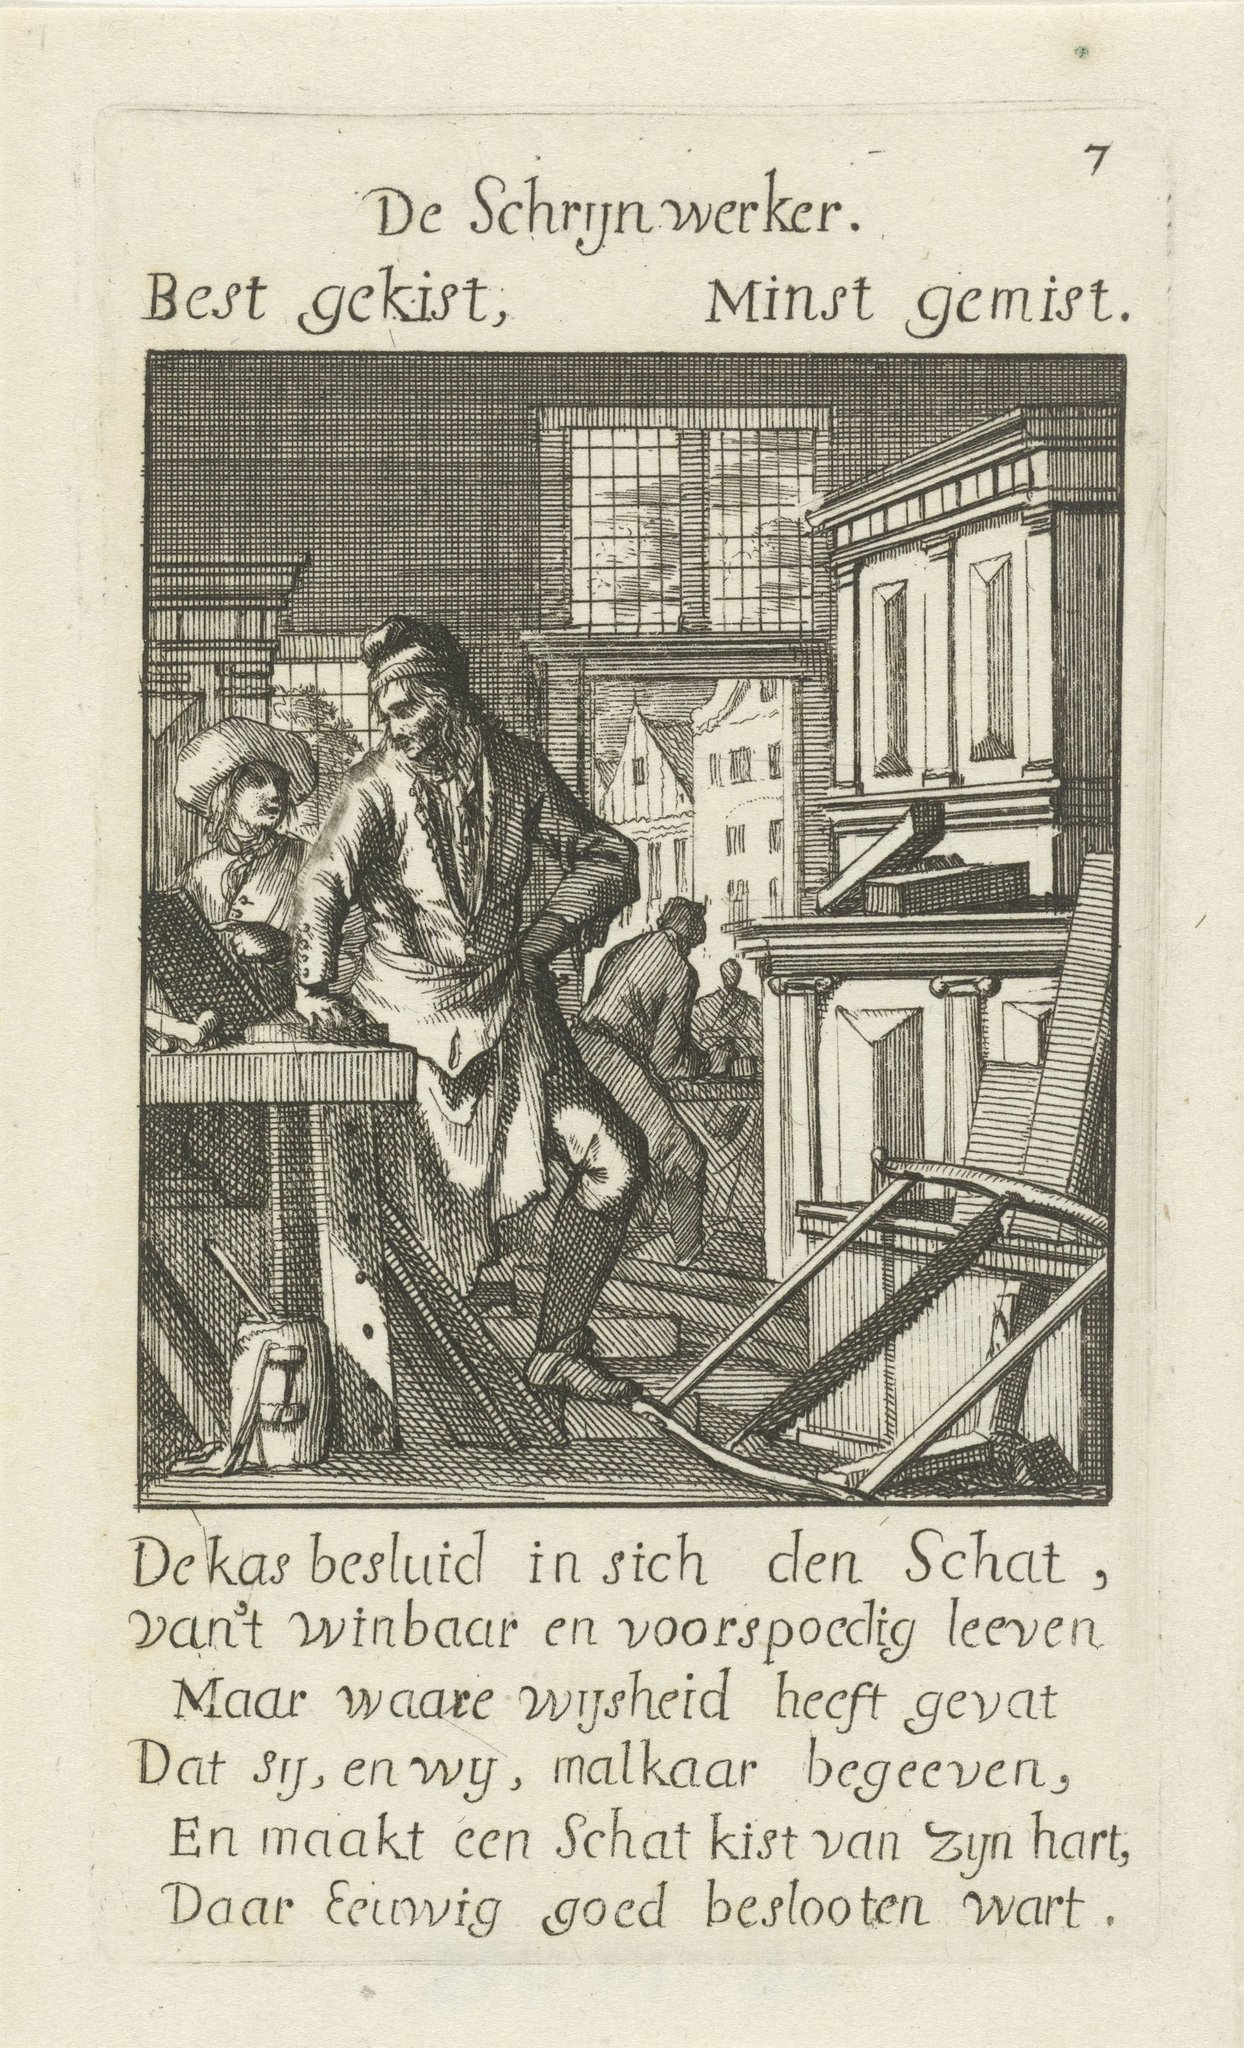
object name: print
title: Schrijnwerker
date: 1694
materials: paper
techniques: etching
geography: amsterdam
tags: joiner, cabinet maker, 'ébéniste', handicrafts, craftsman at work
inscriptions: collector's mark: Lugt 2228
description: Maakt deel uit van de 100-delige serie beroepsprenten van Jan en Caspar Luyken, getiteld: Het menselyk bedryf. S.l.s.n., 1694 (eerste druk).